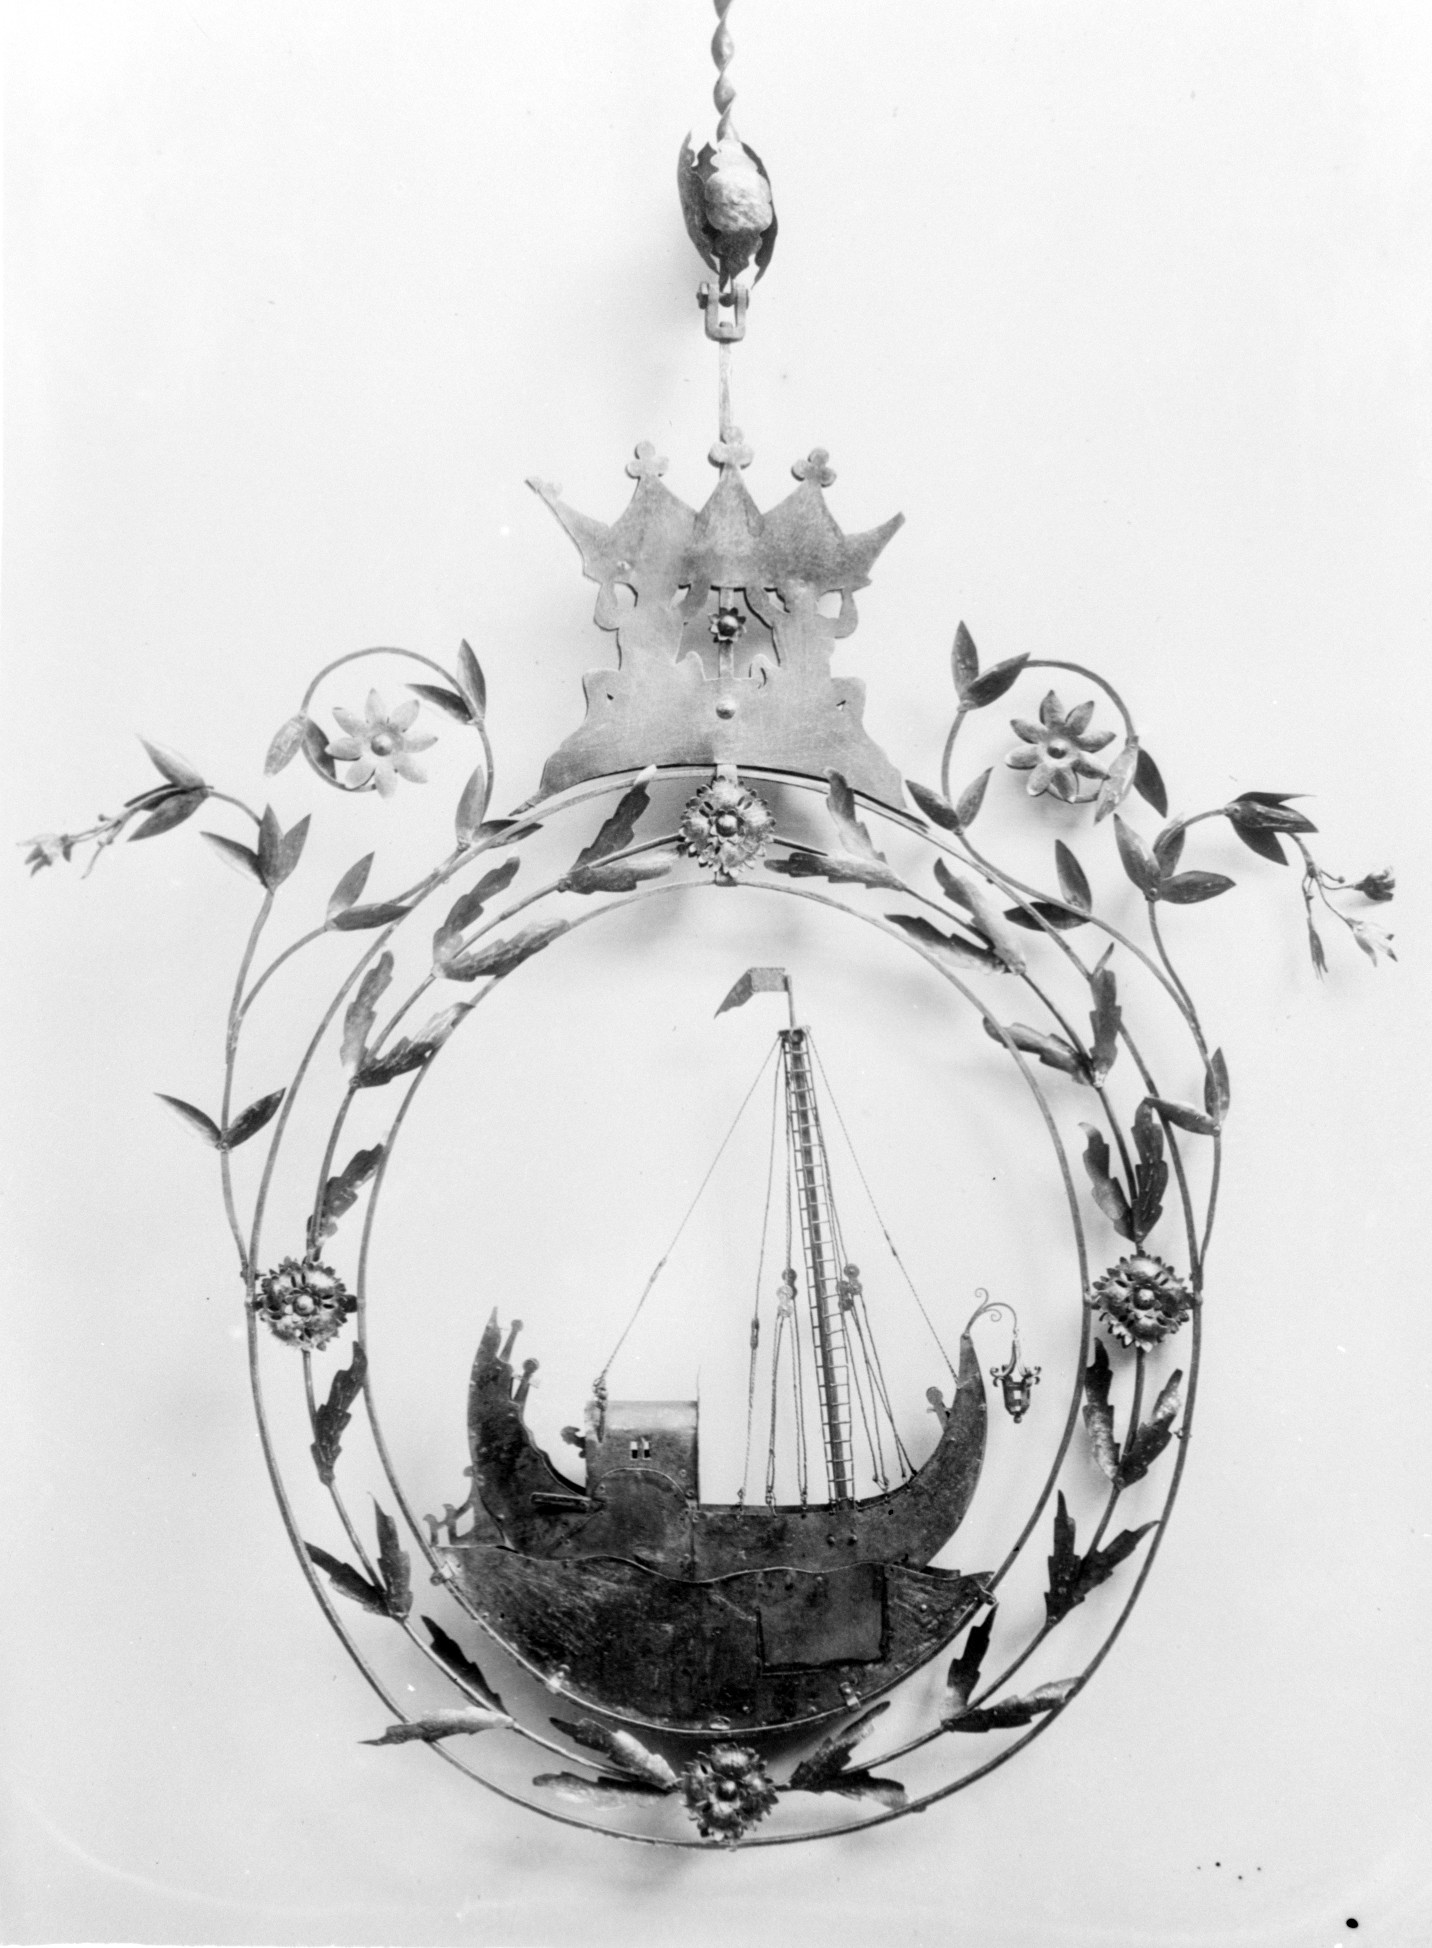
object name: votive offering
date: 1701-1800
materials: iron, paint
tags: flowers,leaves,insignia,ships